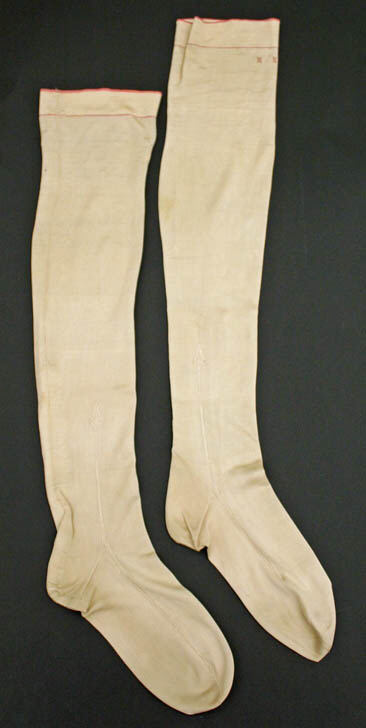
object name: stocking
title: Stockings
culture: american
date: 1859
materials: silk